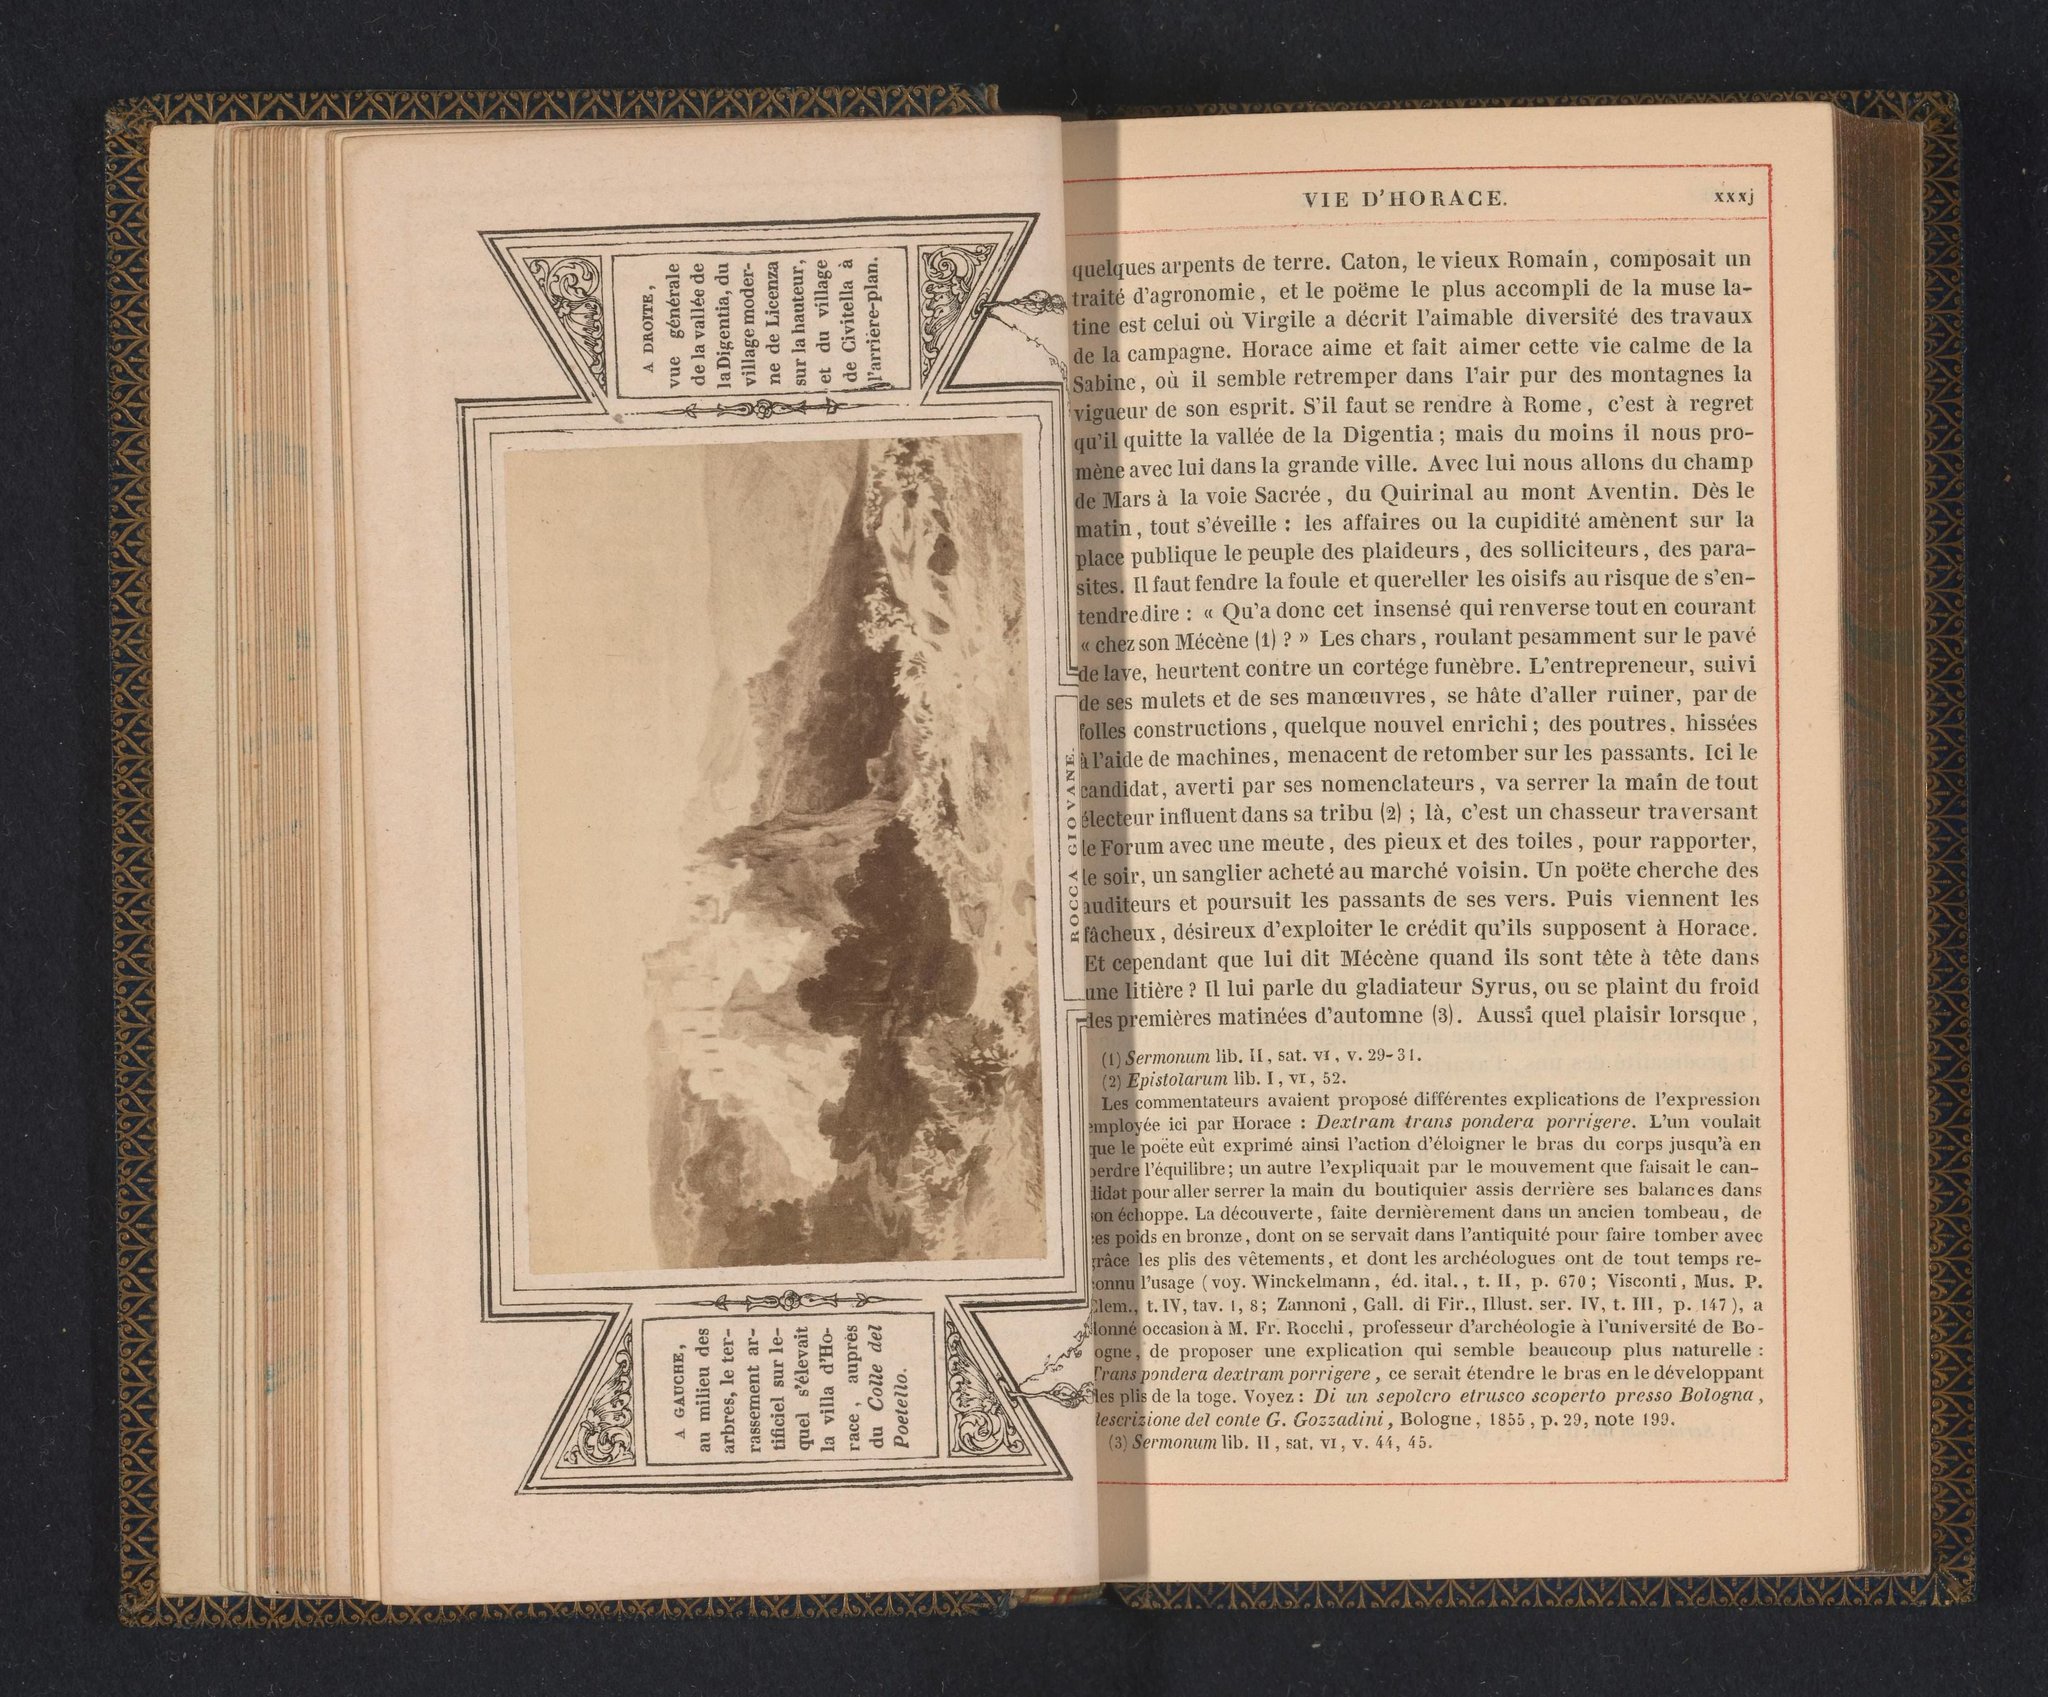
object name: photograph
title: Rocca Giovane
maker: Anonymous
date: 1850-1855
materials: photographic support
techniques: albumen print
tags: city-view in general; 'veduta'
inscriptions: inscription: ‘A gauche (...) l'arrière-plan.’